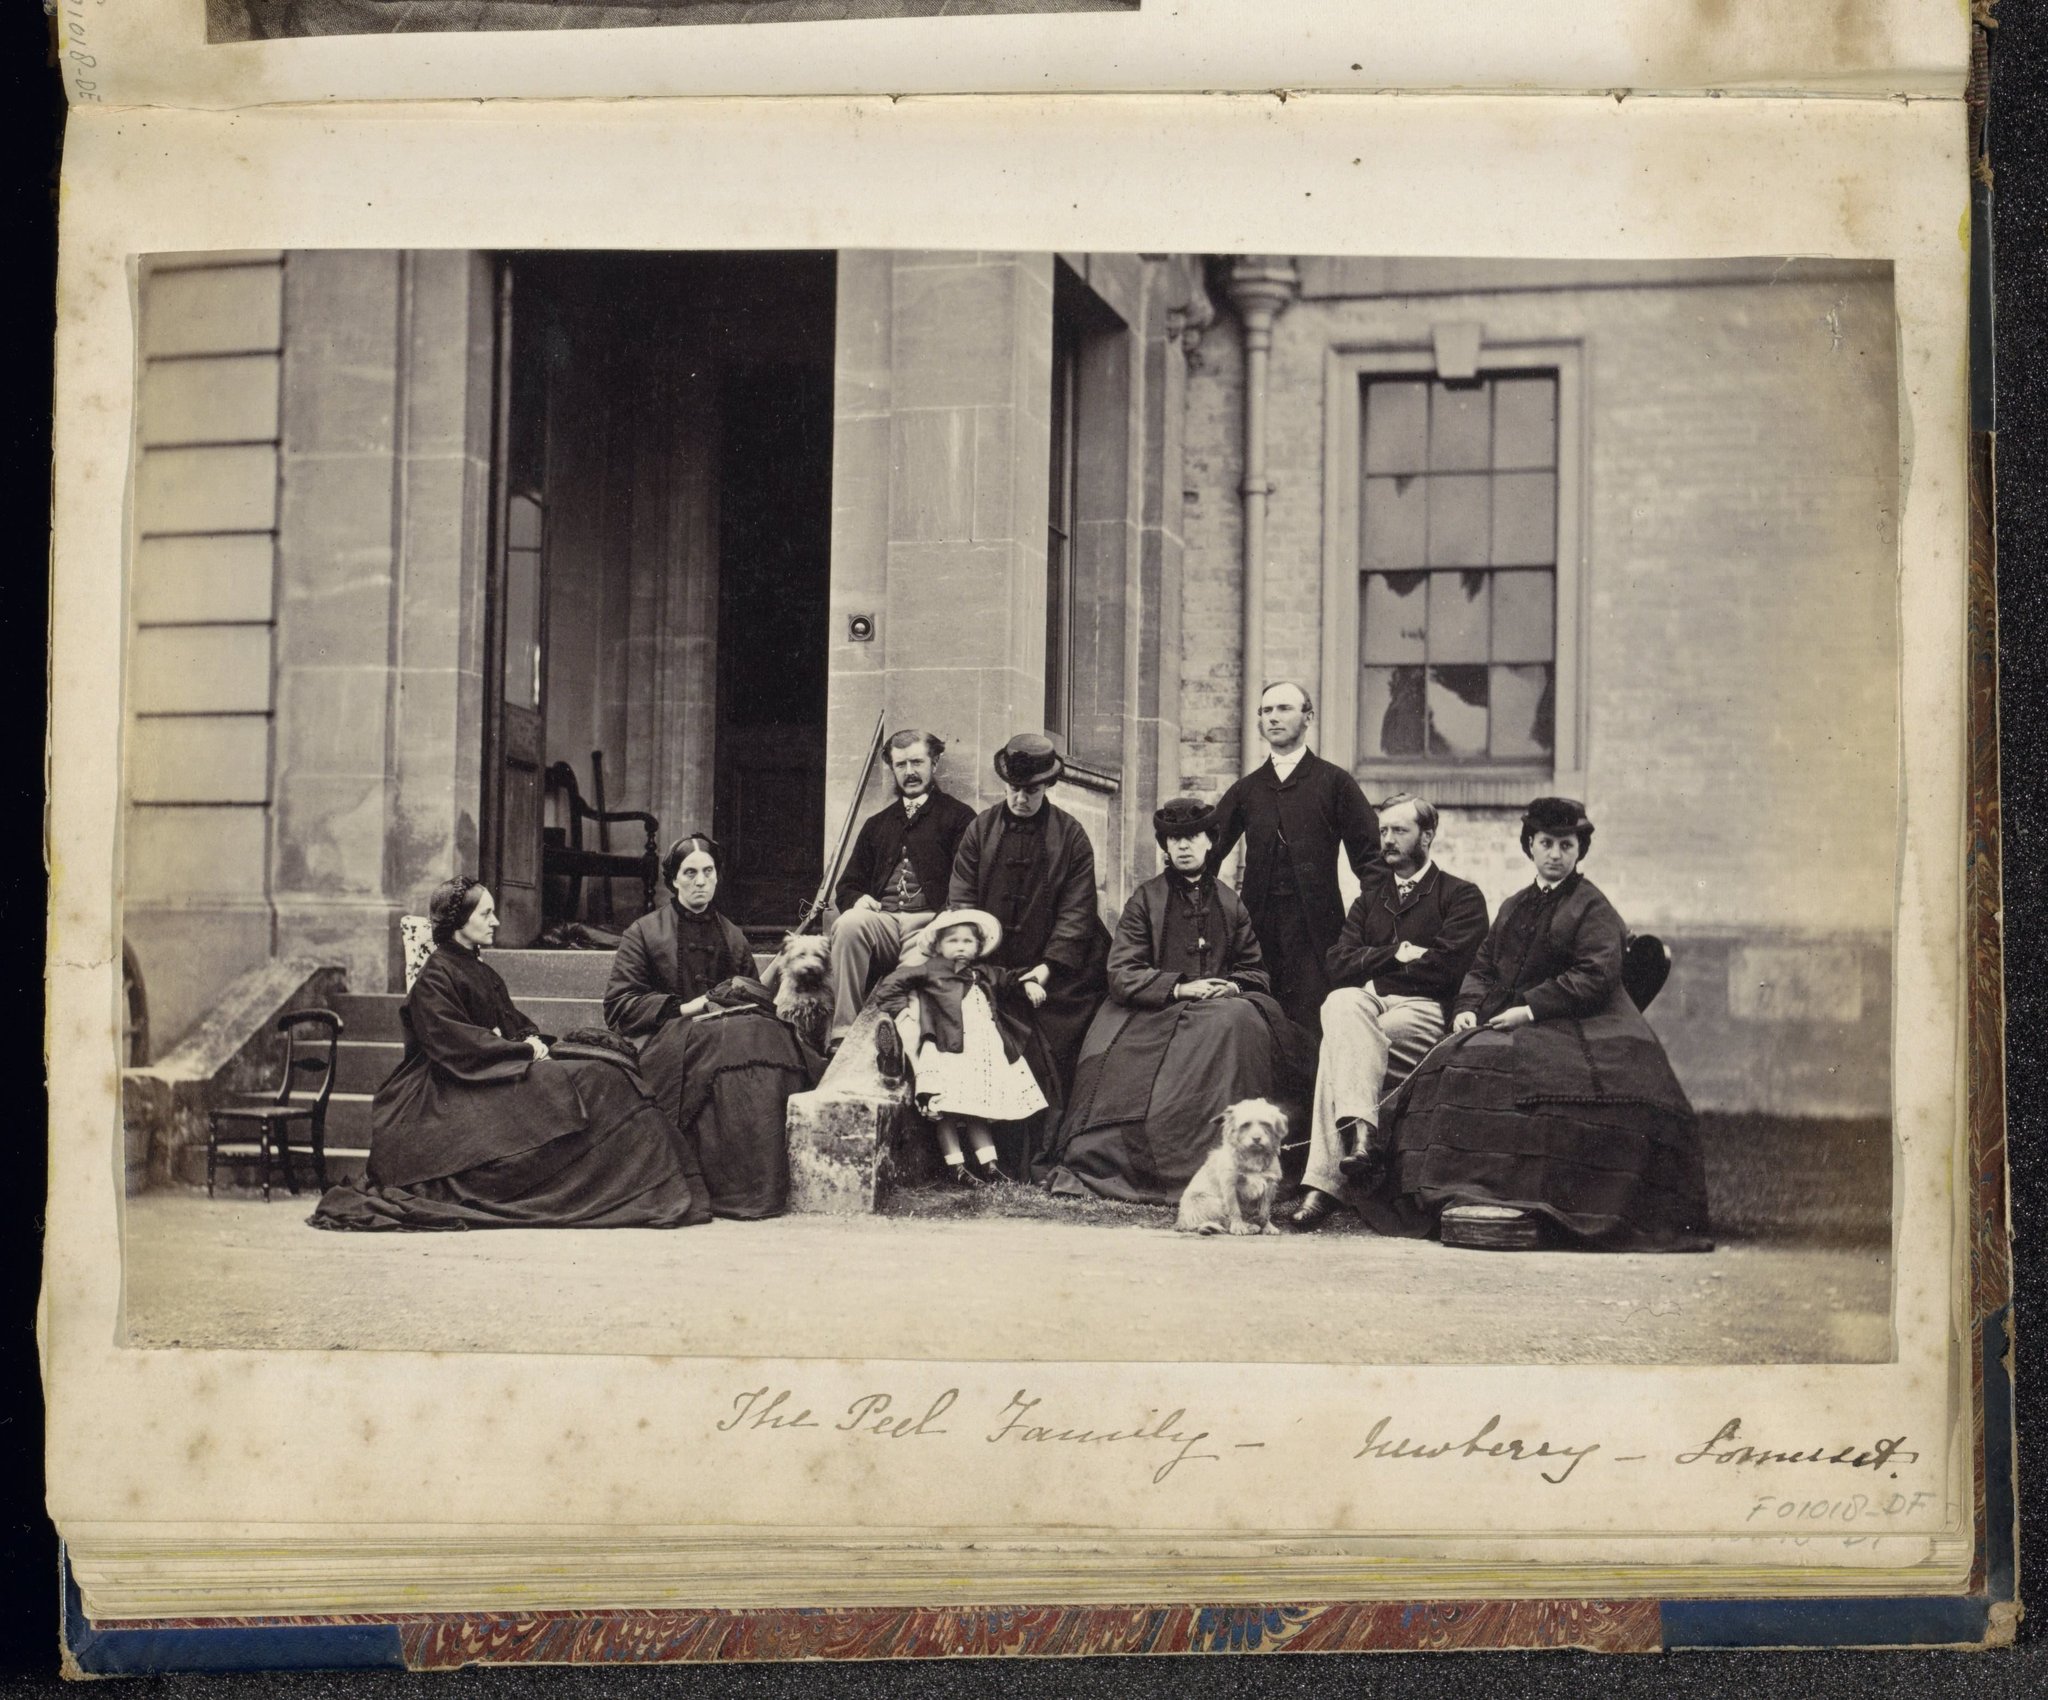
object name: photograph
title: Portret van de familie Peel voor een landhuis in Newbury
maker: Anonymous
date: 1860-1865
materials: paper, photographic support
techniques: albumen print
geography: newbury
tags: head-gear, trousers, breeches, clothing for the upper part of the body, villa, dress, gown, three generations (family group), dog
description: Onderdeel van Engels familiealbum met foto's van personen, reizen, cricket en kunstwerken.